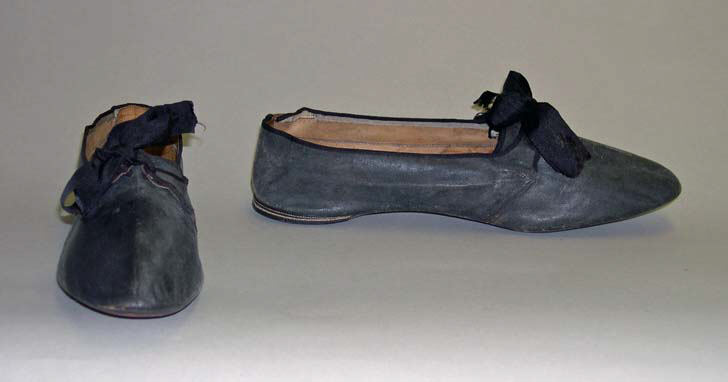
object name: slipper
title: Slippers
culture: american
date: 1810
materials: leather